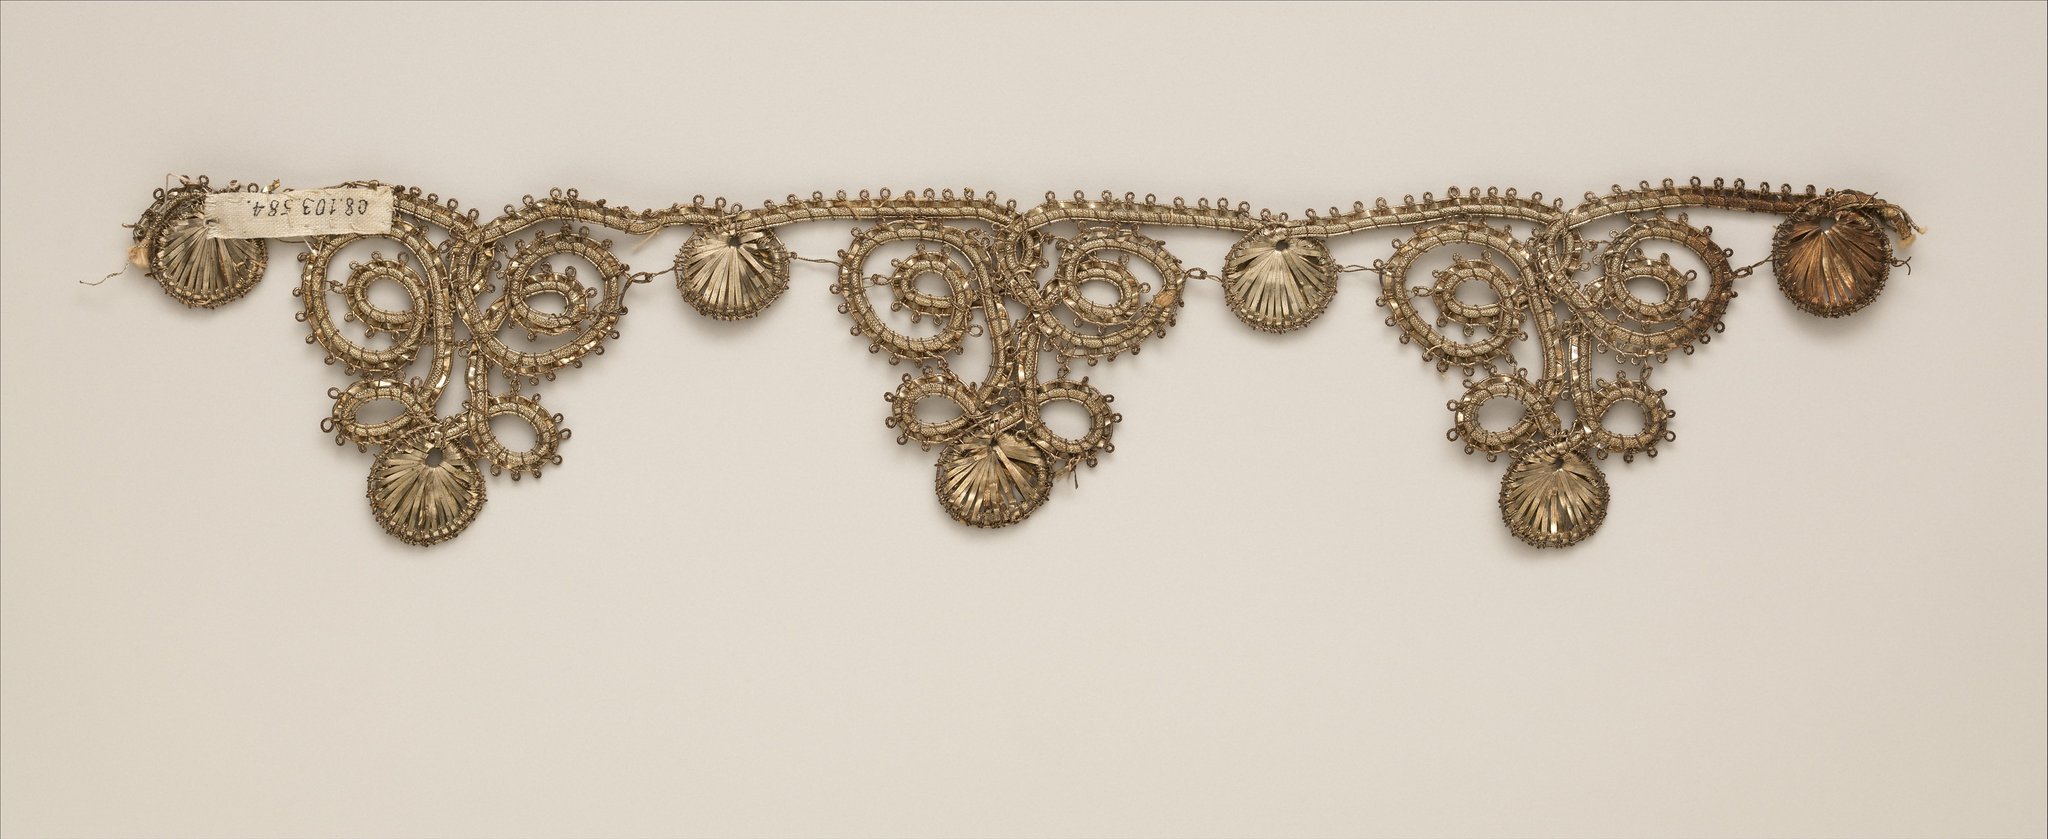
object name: galloon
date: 1601-1800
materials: metal thread